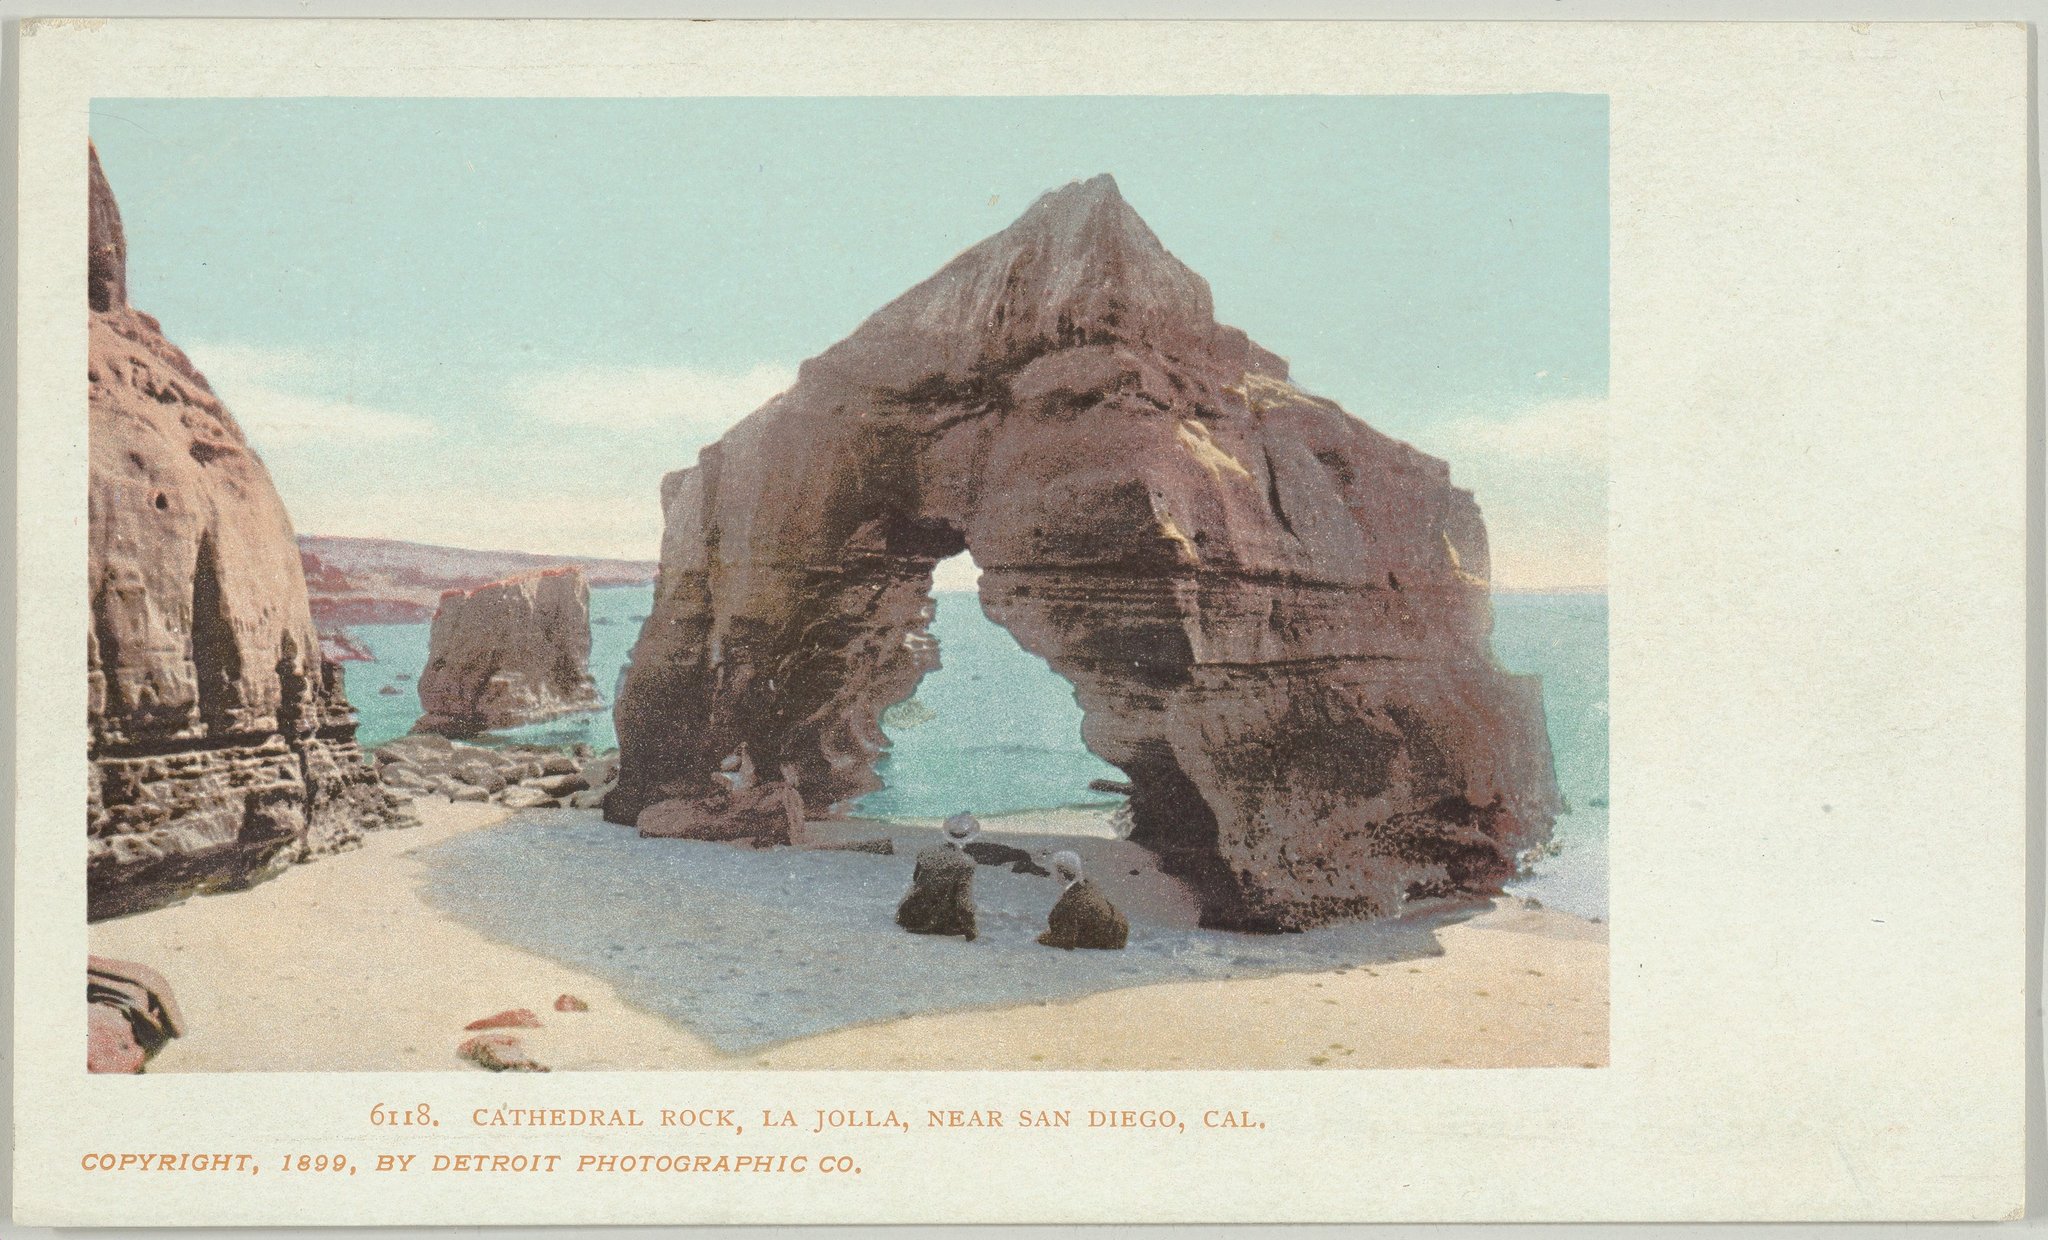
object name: print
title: Cathedral Rock, La Jolla, Near San Diego, California, No. 6118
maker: detroit publishing company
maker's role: publisher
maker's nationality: american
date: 1899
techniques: color lithograph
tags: beaches,seascapes